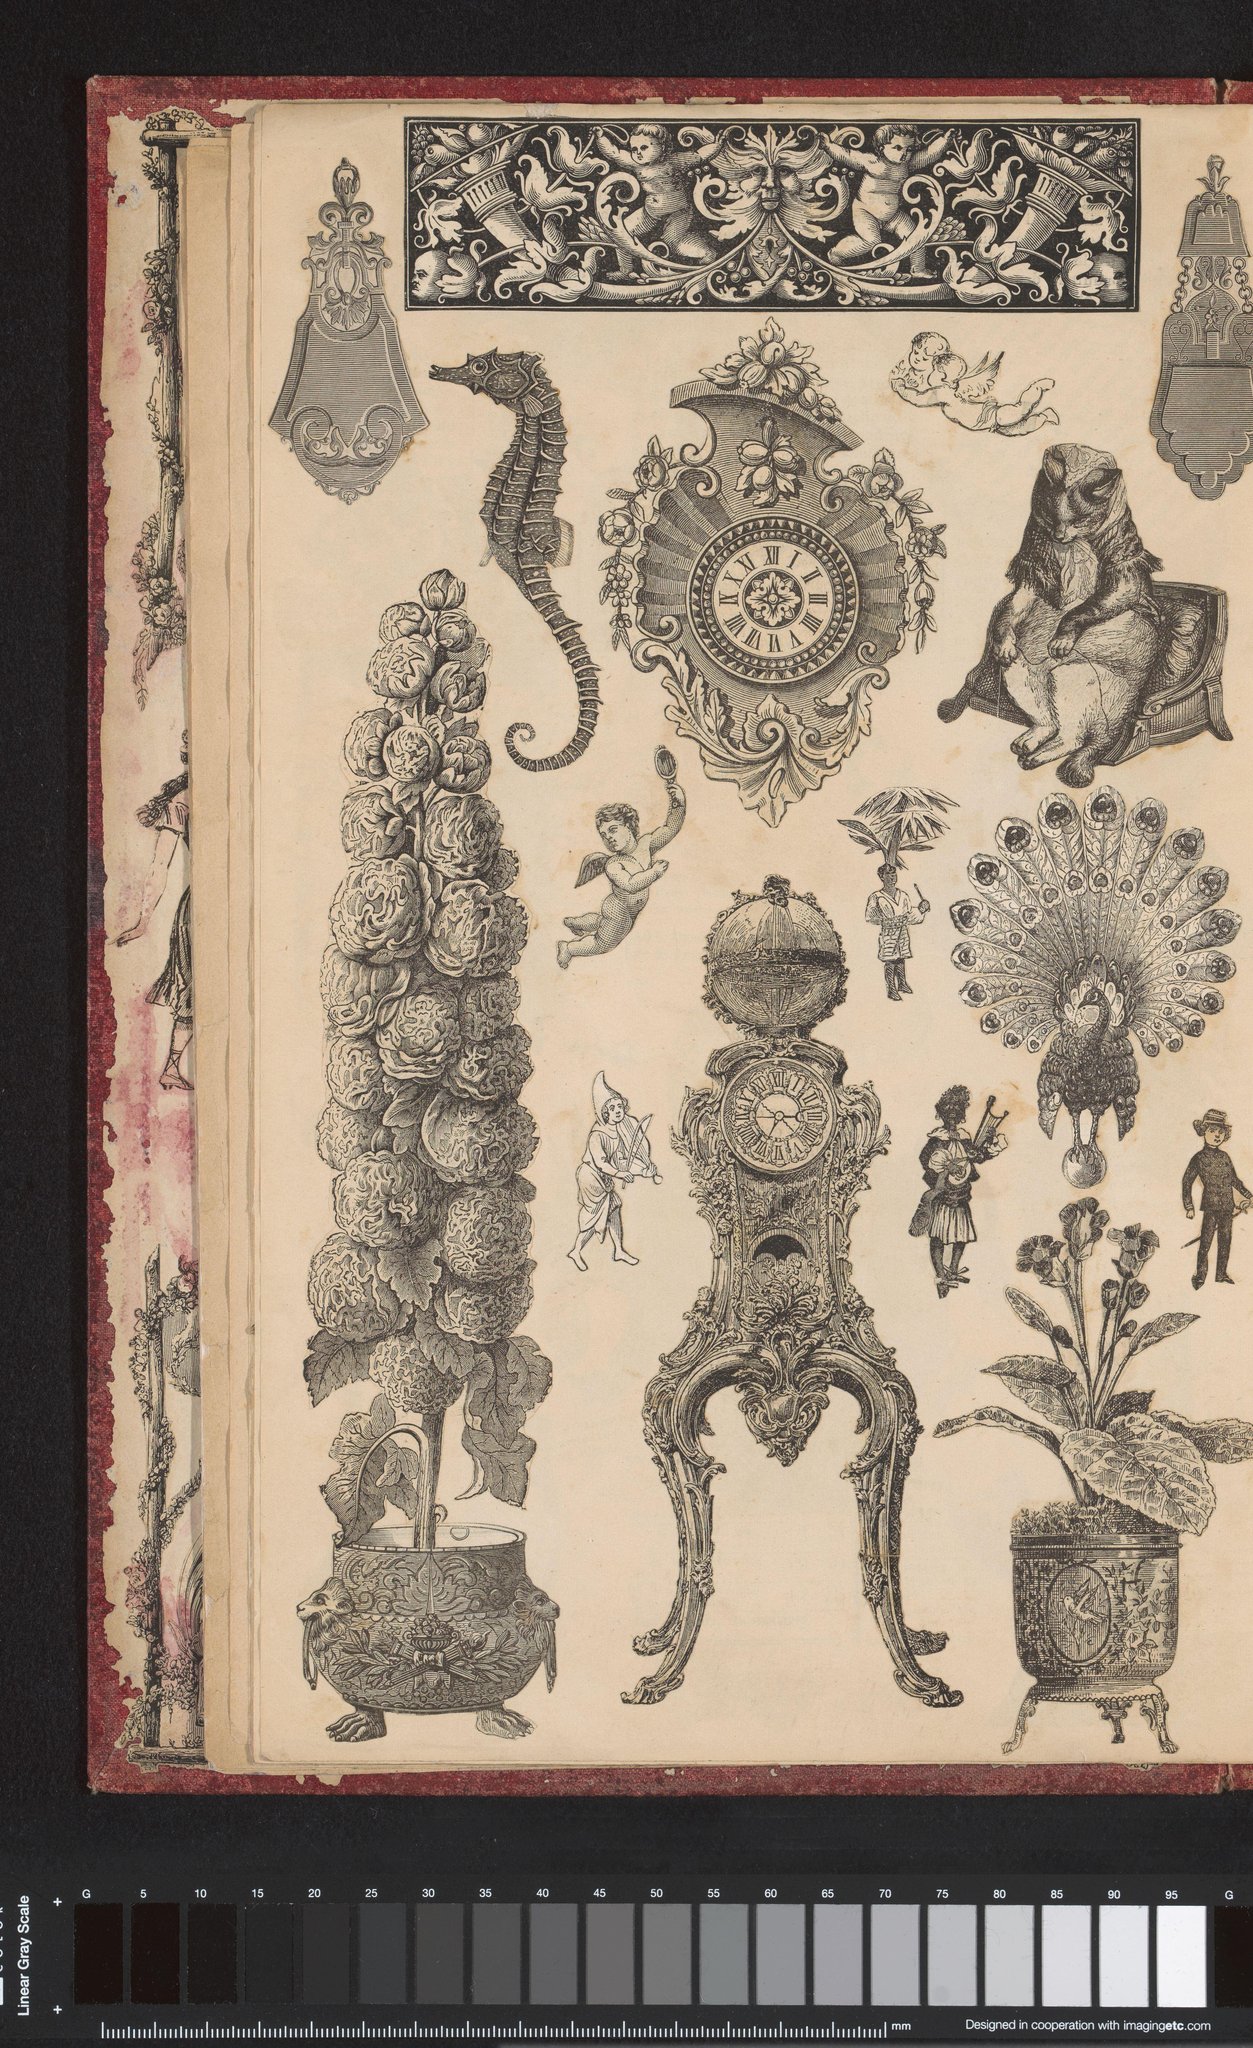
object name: print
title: Collage van uitgeknipte prenten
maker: Anonymous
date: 1870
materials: paper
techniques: engraving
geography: paris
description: Collage van uitgeknipte prenten. Onderdeel van een album met 32 bladen, aan beide zijden beplakt met uitgeknipte prenten, vermoedelijk afkomstig uit 19e-eeuwse tijdschiften.